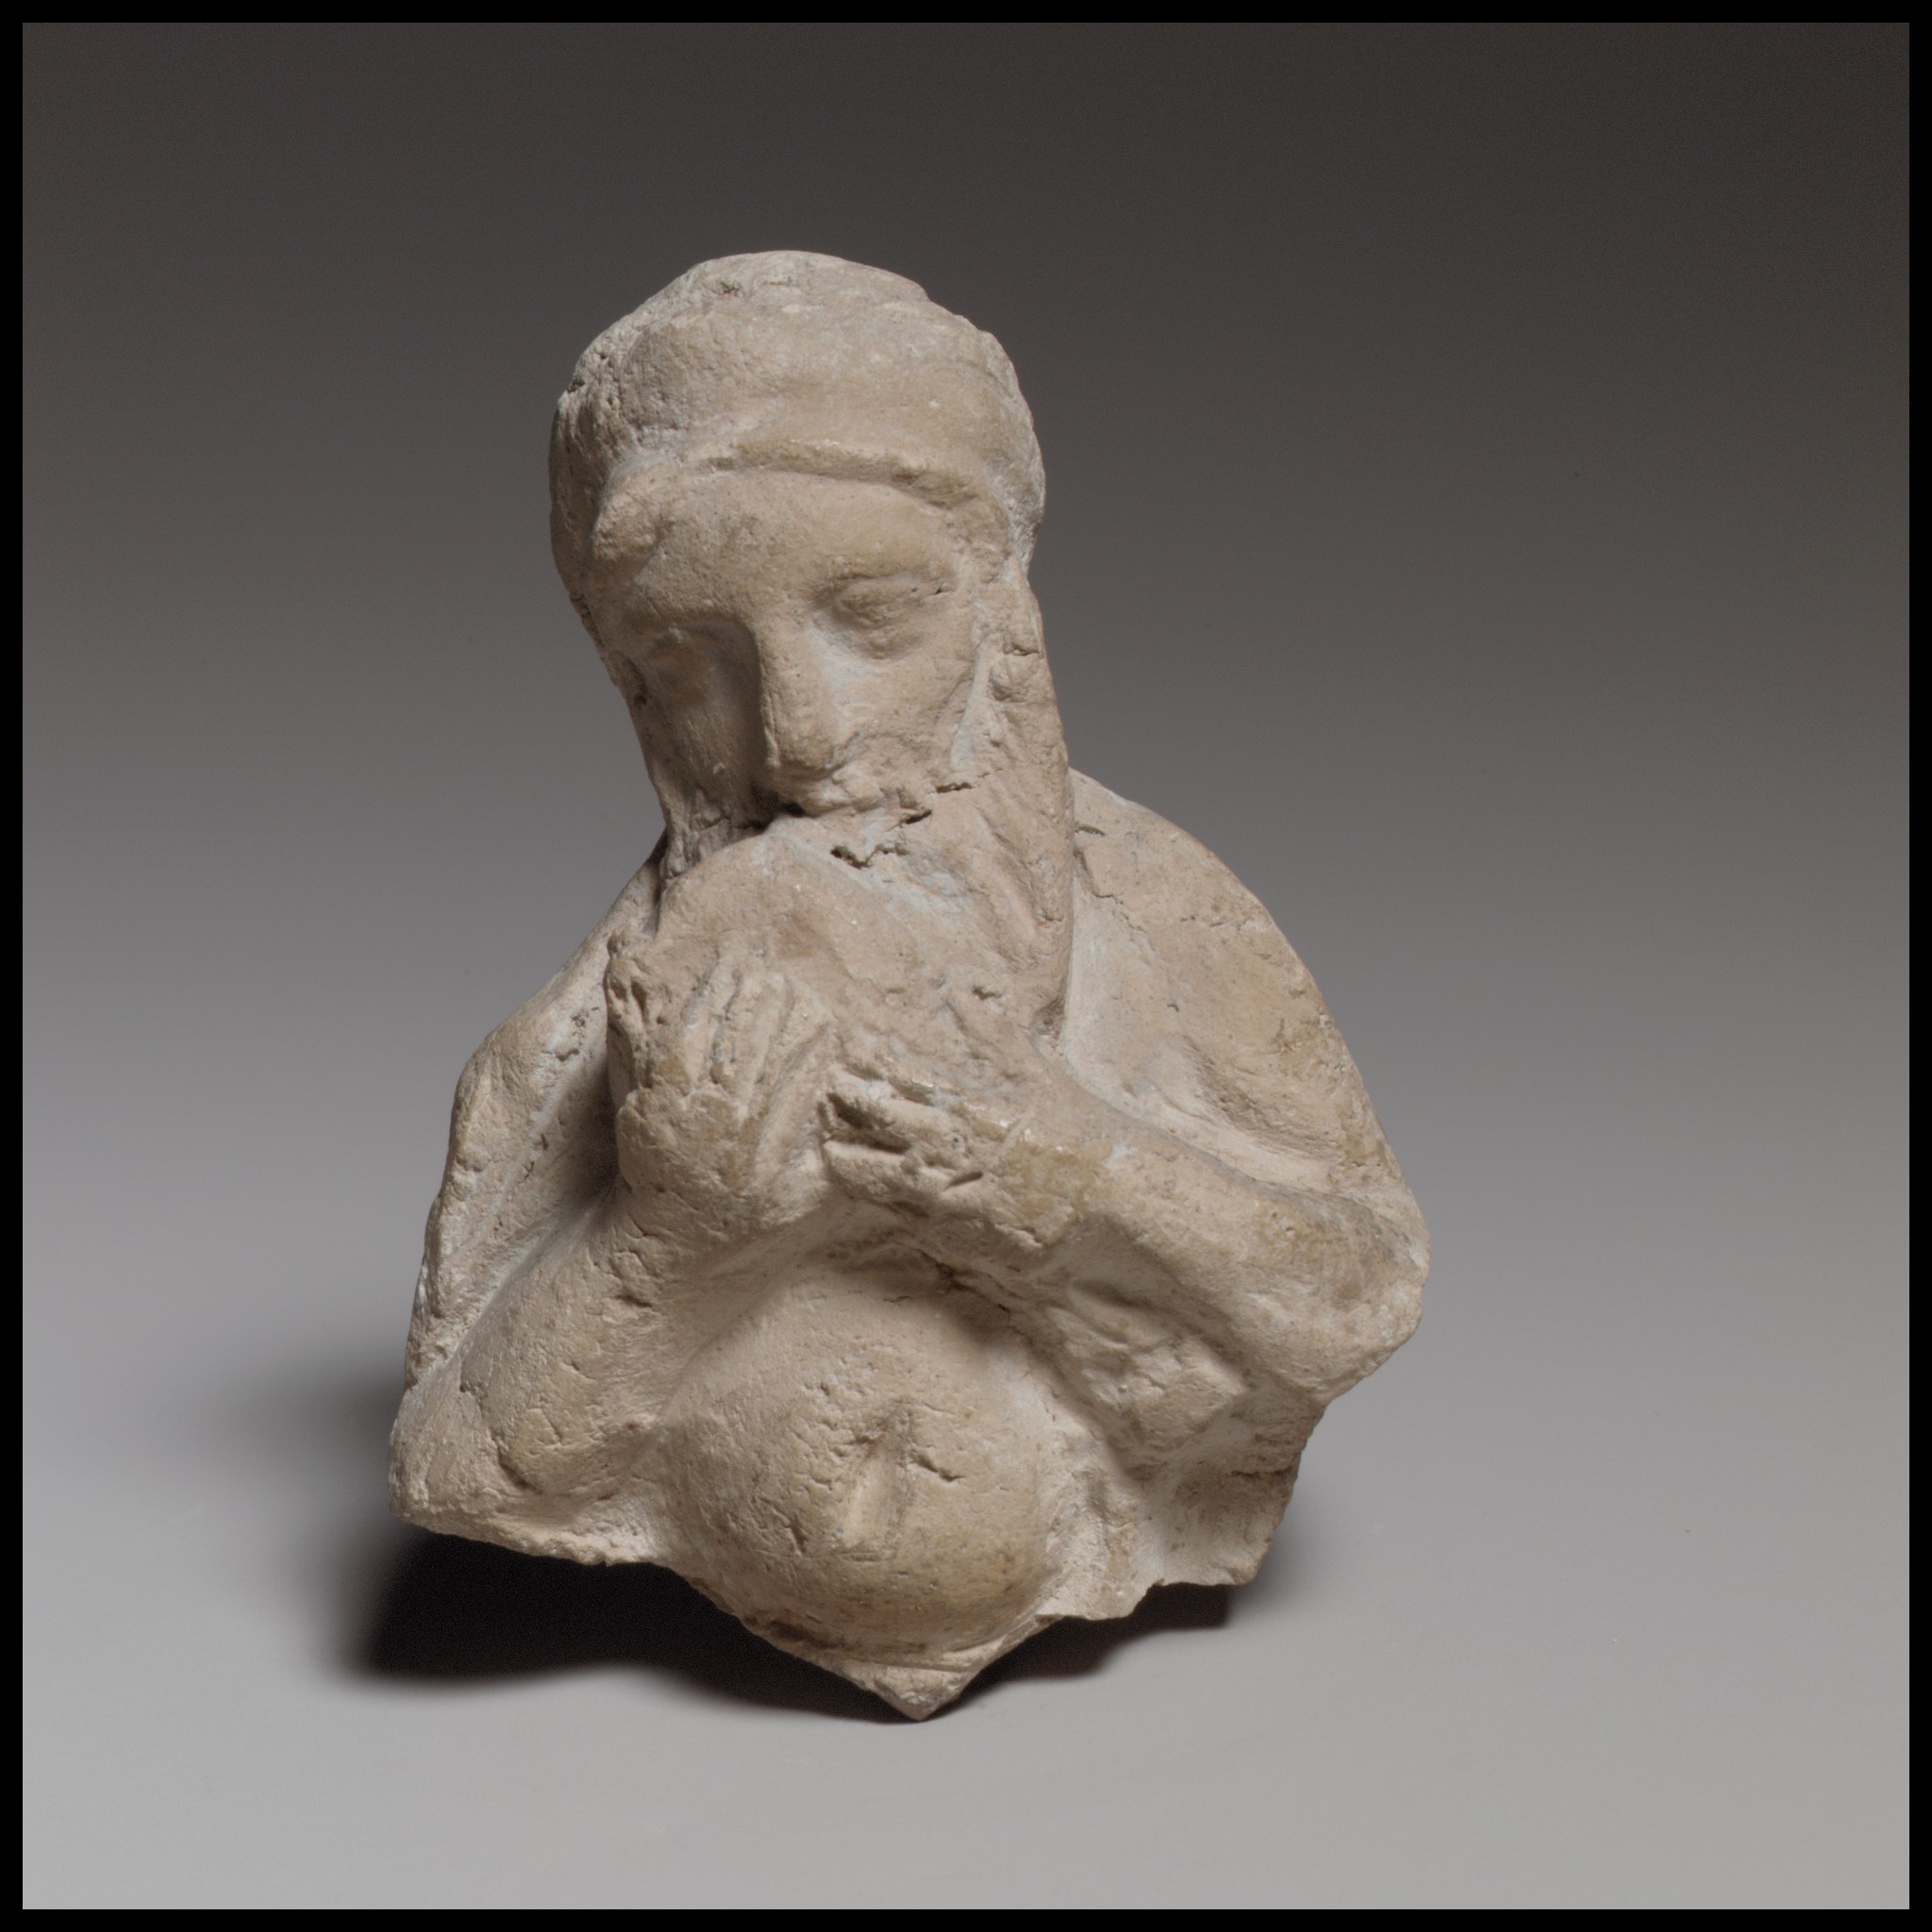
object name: statue of silenos drinking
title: Terracotta statuette of Silenos (?) drinking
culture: cypriot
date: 300-201 BCE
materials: terracotta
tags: men,drinking